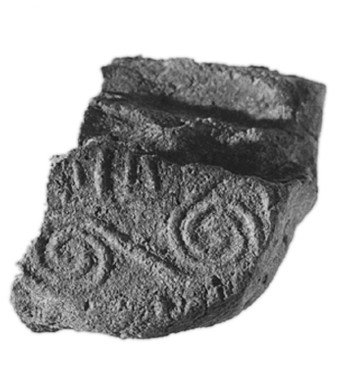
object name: sealing fragment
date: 2030-1640 BCE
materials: clay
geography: egypt